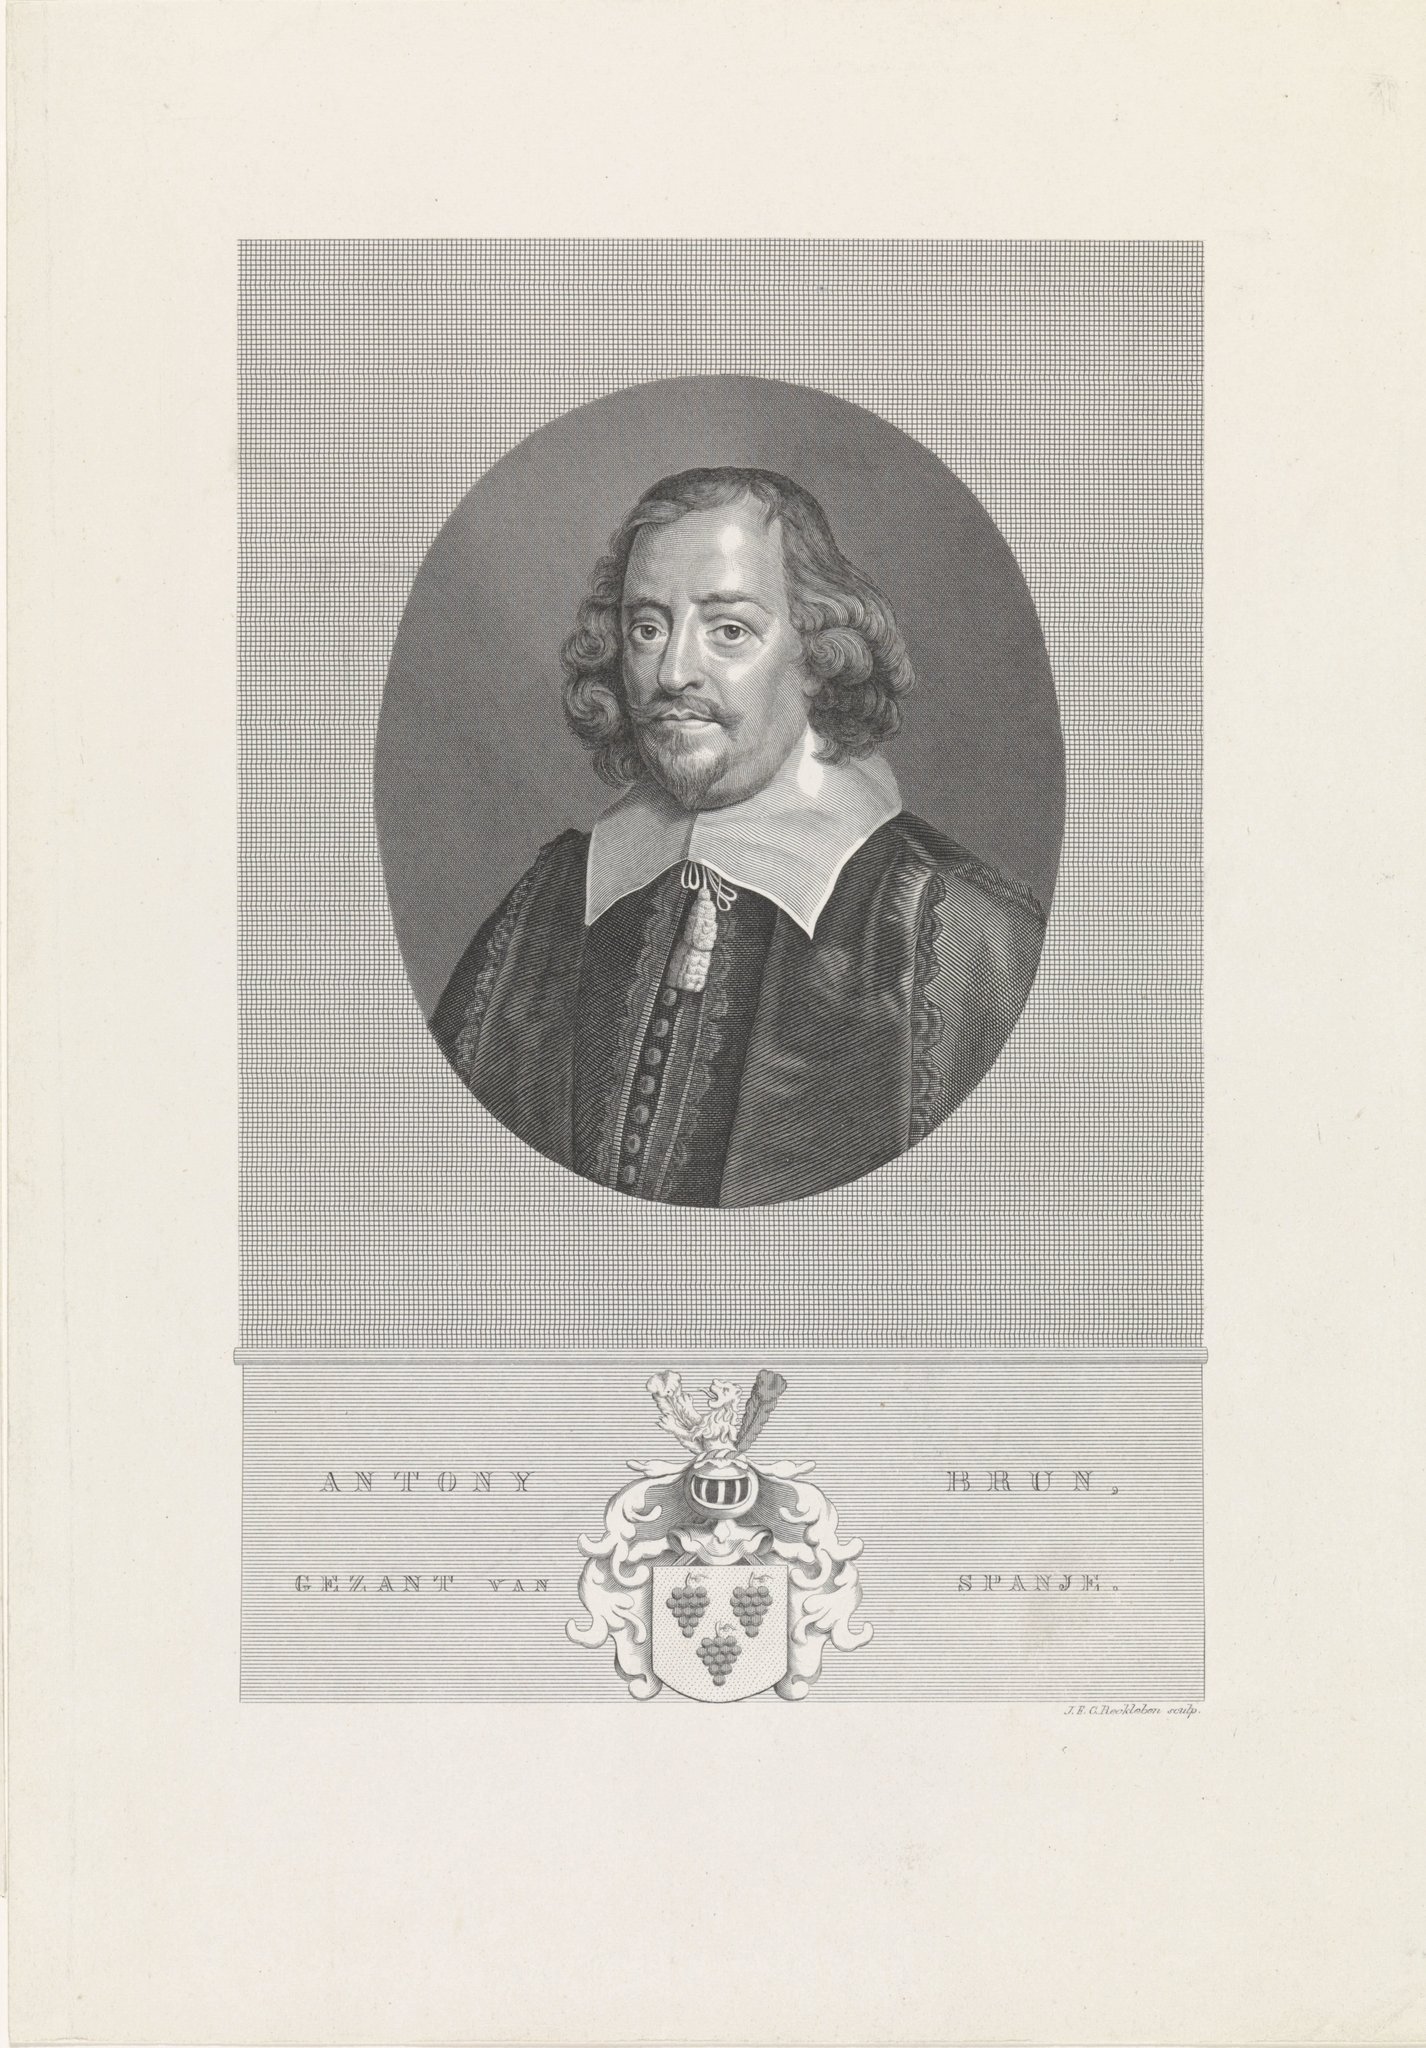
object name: print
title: Portret van Antoine Brun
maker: jan frederik christiaan reckleben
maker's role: print maker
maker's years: 1819-1879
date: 1877-1879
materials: paper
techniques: engraving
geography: amsterdam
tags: antoine brun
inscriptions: collector's mark: Lugt 2166, collector's mark: Lugt 2760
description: Illustratie in: Arend, Johannes Pieter. Algemeene geschiedenis des vaderlands van de vroegste tijden tot op heden. 5 delen, Amsterdam: Schleijer, J.F. 1840-1884, dl. 4.1, p. 80.